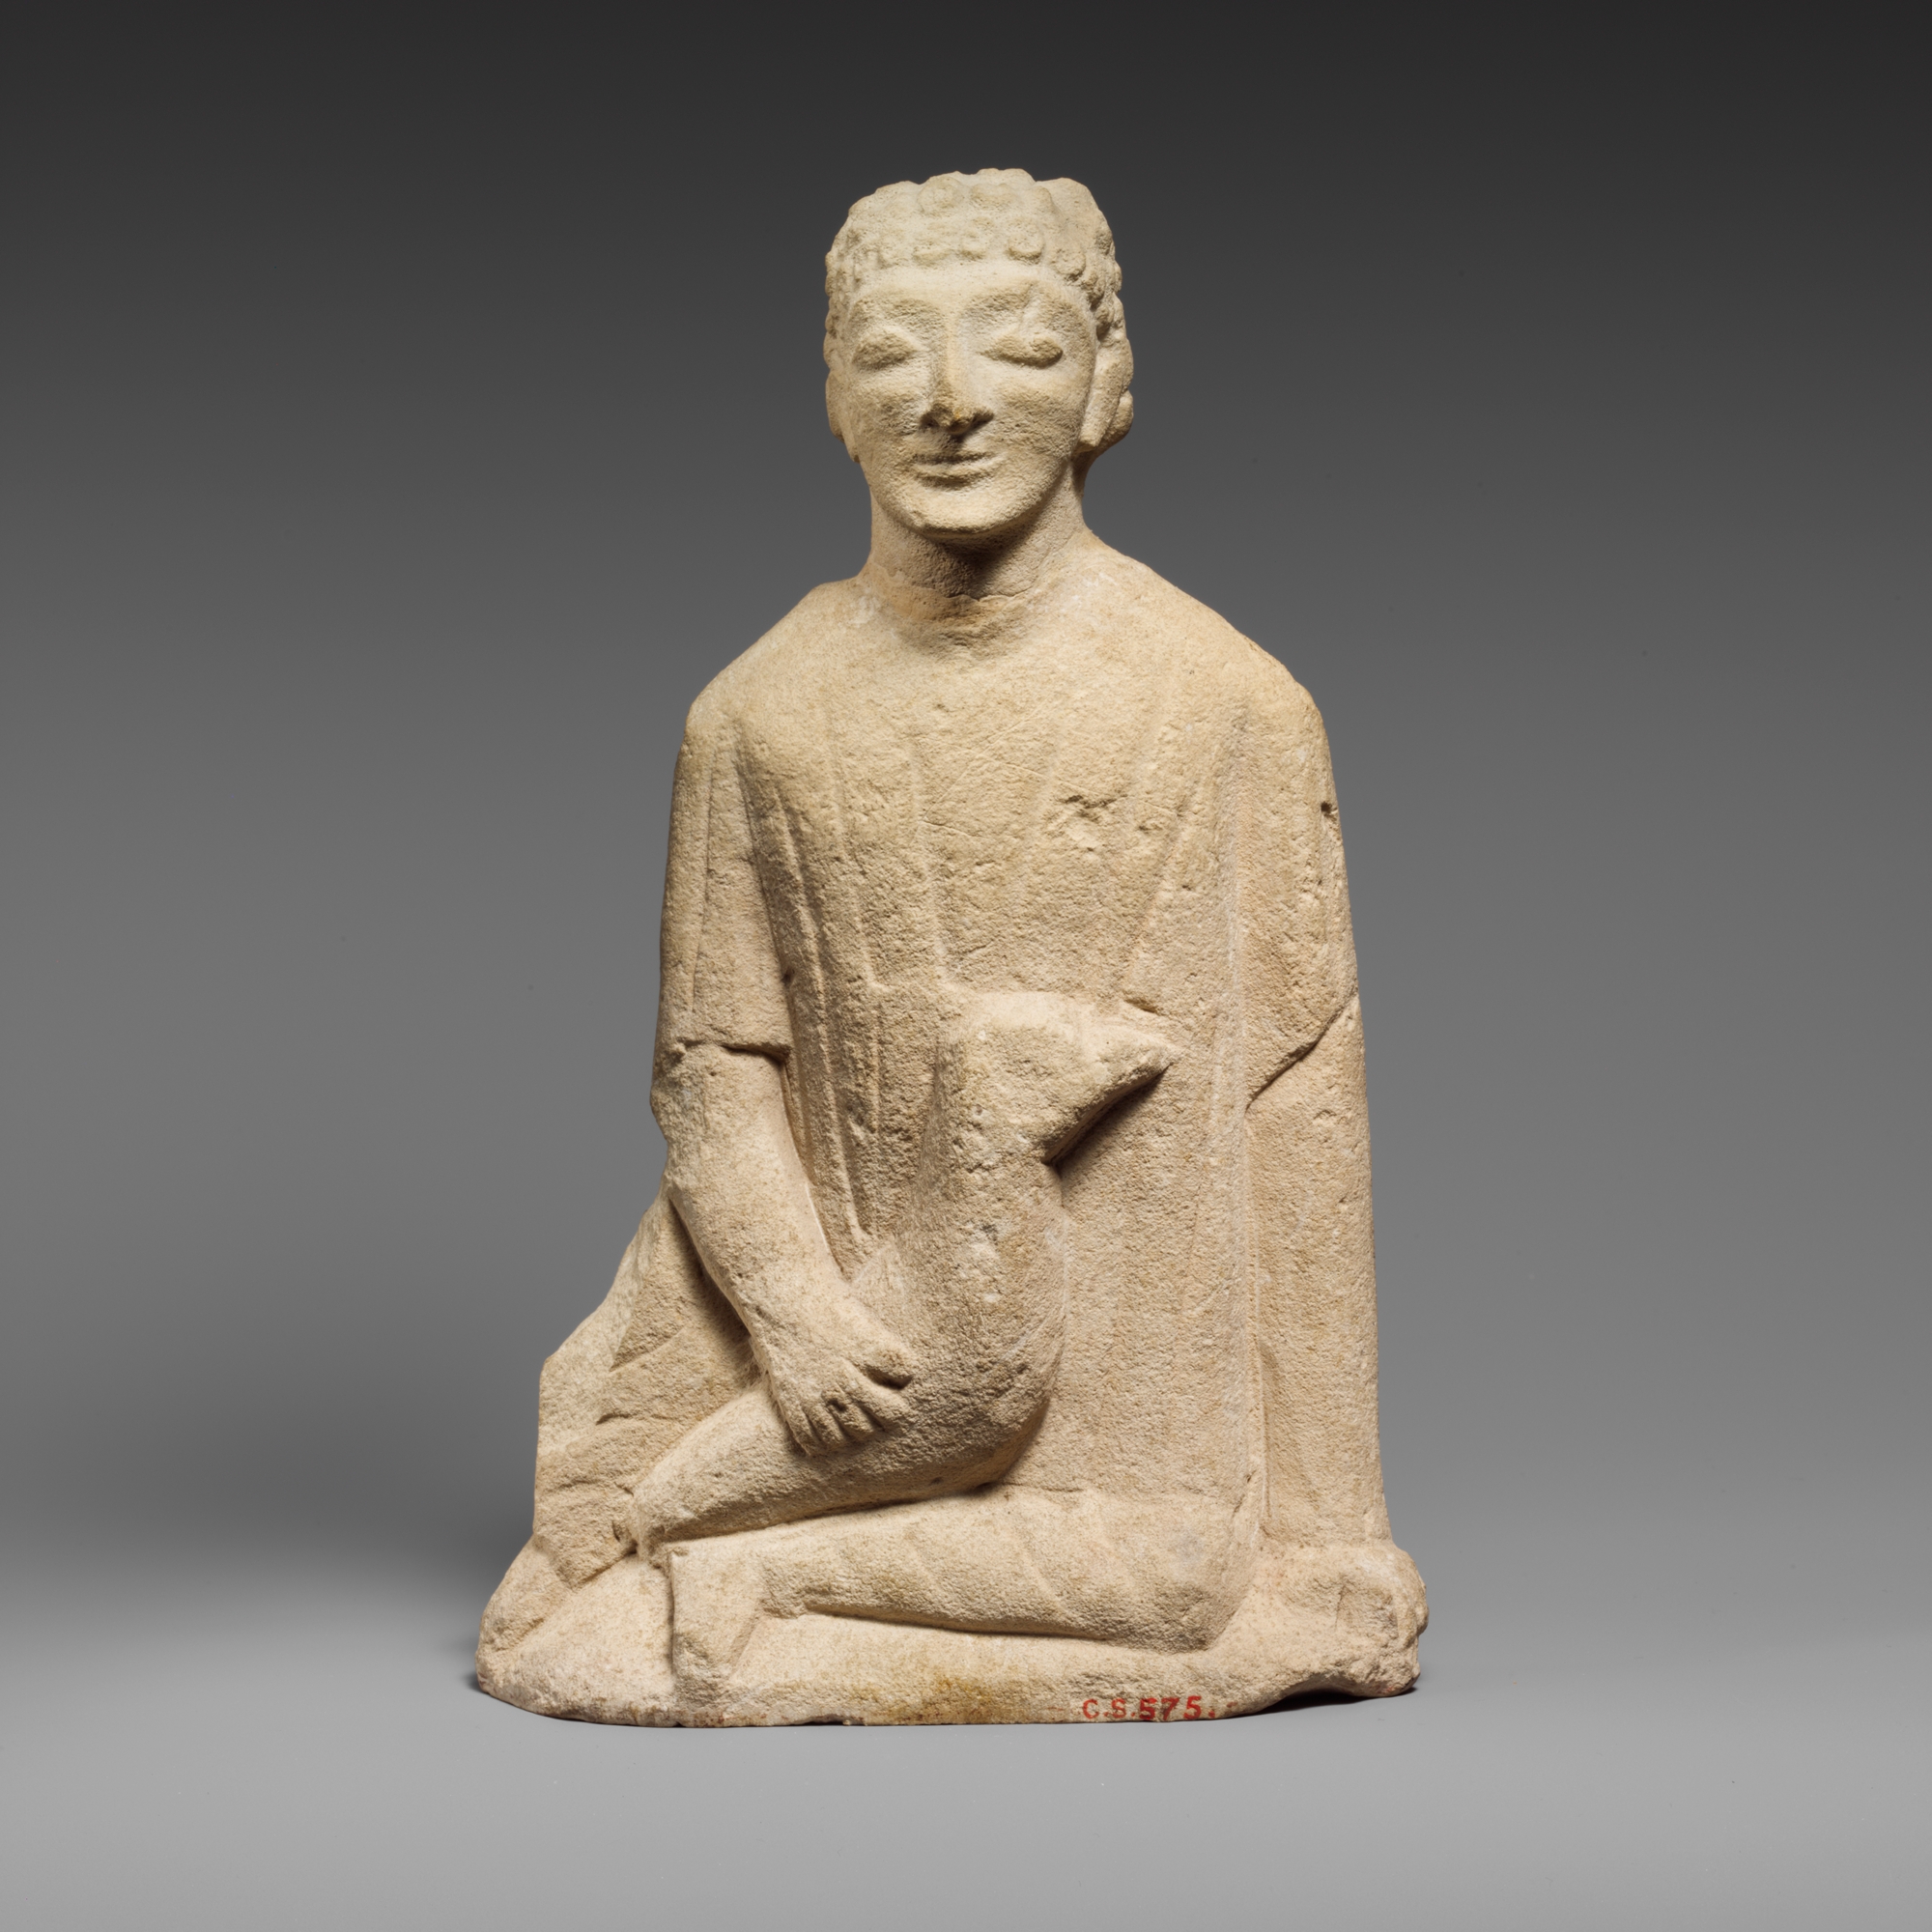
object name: statuette of a temple boy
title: Limestone statuette of a temple boy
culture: cypriot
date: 400-301 BCE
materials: limestone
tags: birds,boys